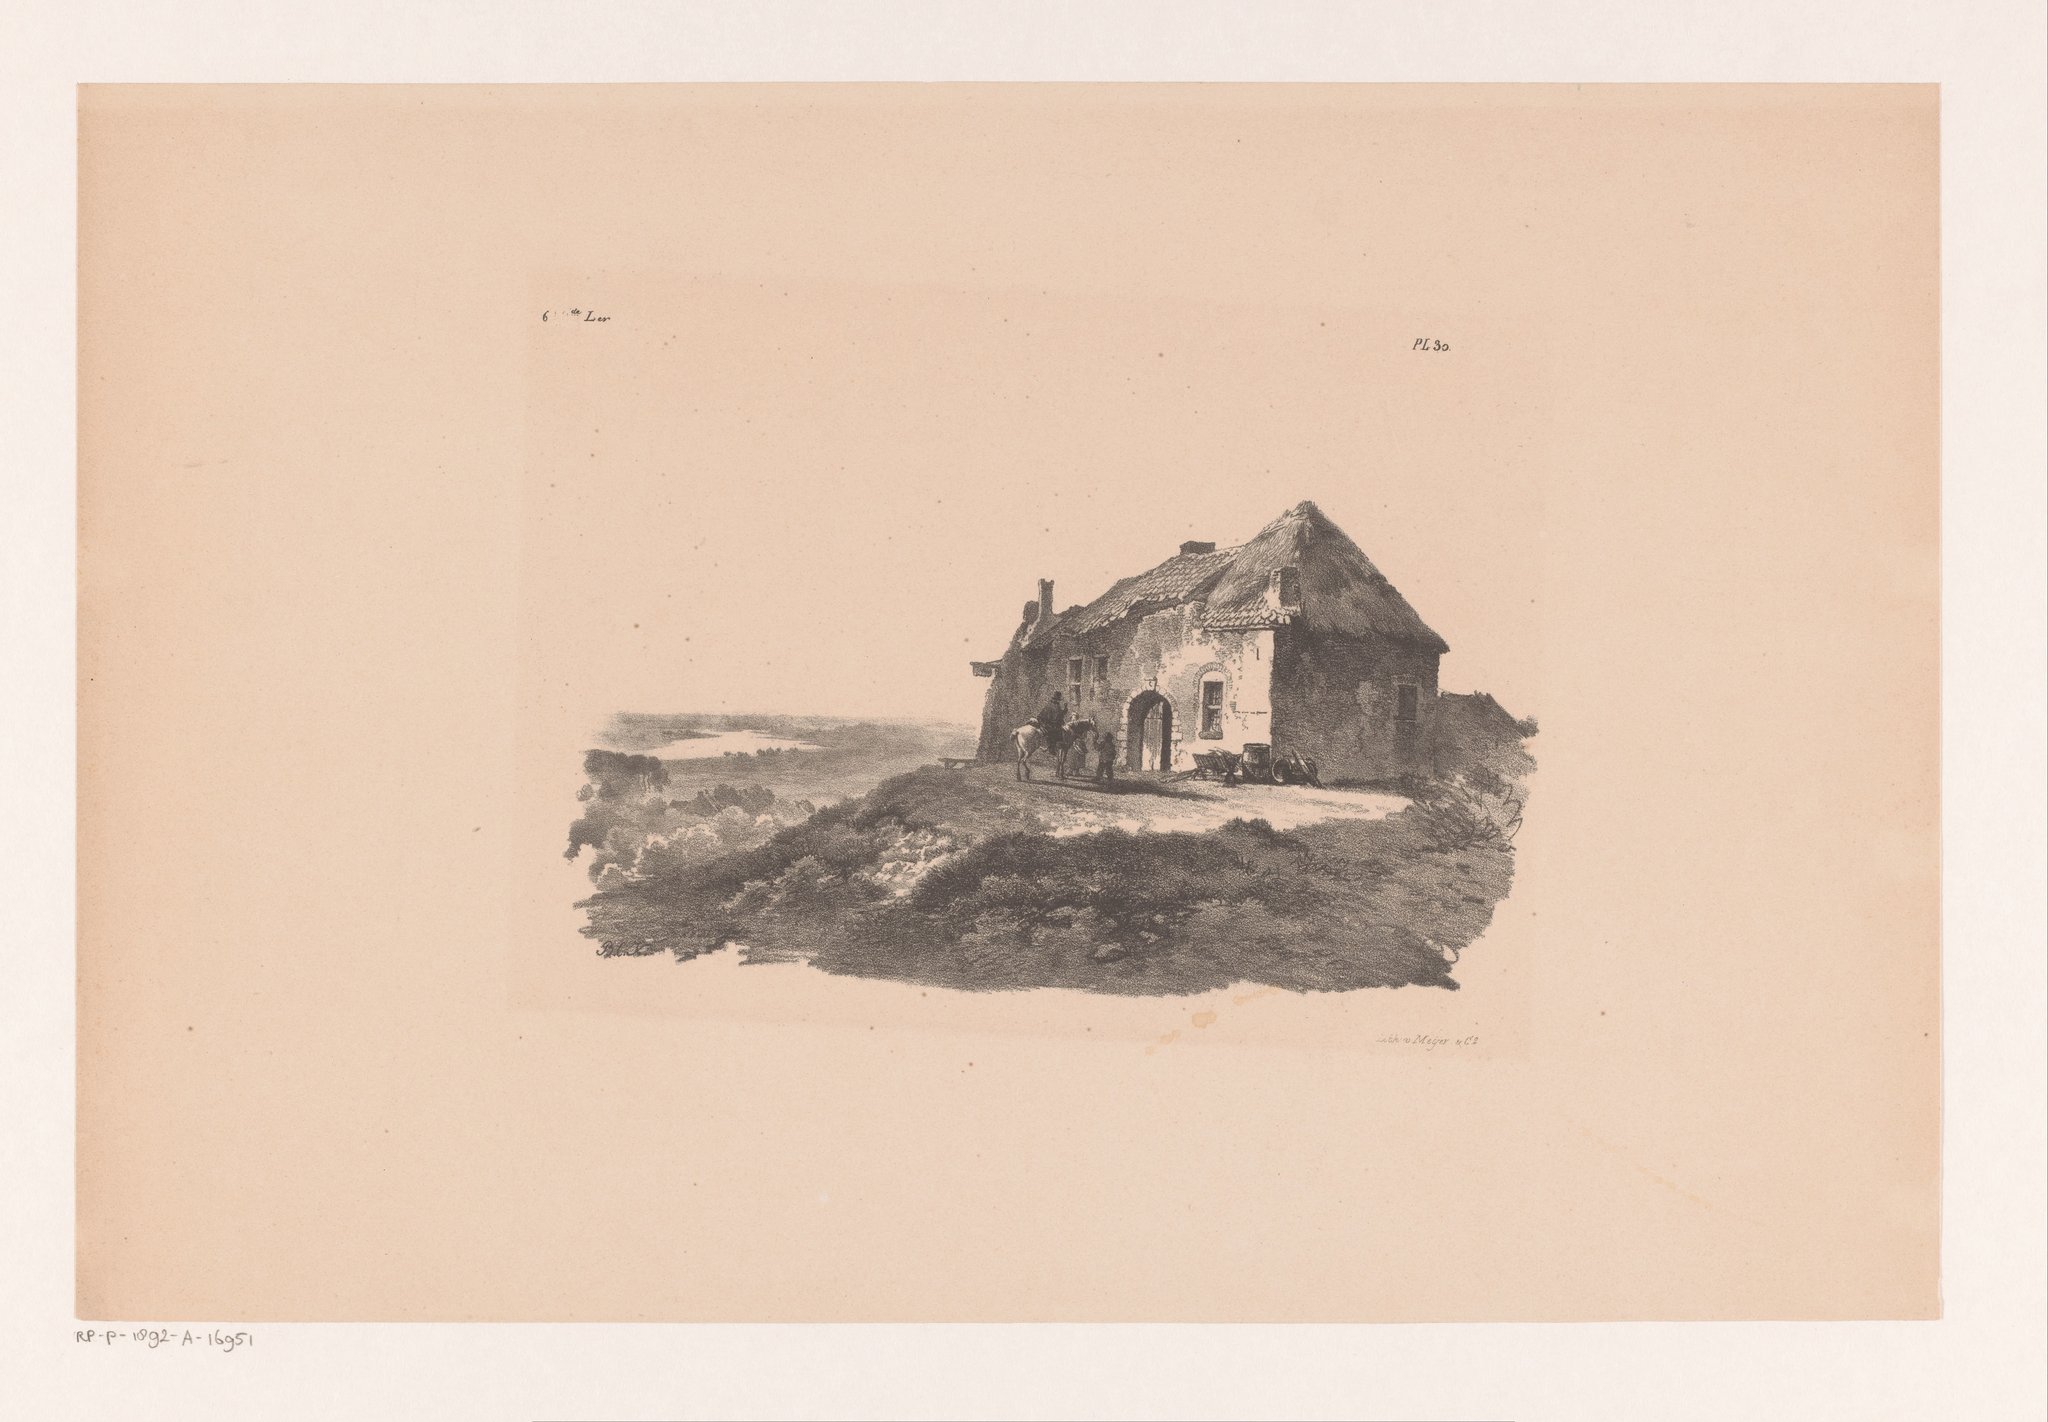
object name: print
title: Landschap studiën zesde levering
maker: barend cornelis koekkoek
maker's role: draughtsman, painter, print maker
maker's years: 1803-1862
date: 1844-1845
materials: paper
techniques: lithograph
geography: amsterdam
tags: riding a horse, ass, or mule; rider, horseman, farm or solitary house in landscape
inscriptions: collector's mark: Lugt 2228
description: In 1829 en 1830 gaf Koekkoek, samen met Daiwaille, zes cahiers uit met ieder zes prenten getiteld Landschapstudiën. Deze werden gebruikt in het tekenonderwijs. Vijftien jaar later werd deze reeks, in een andere samenstelling nogmaals uitgegeven door Meyer en Comp in Amsterdam. Zie: De Bruyn Kops, 1963.